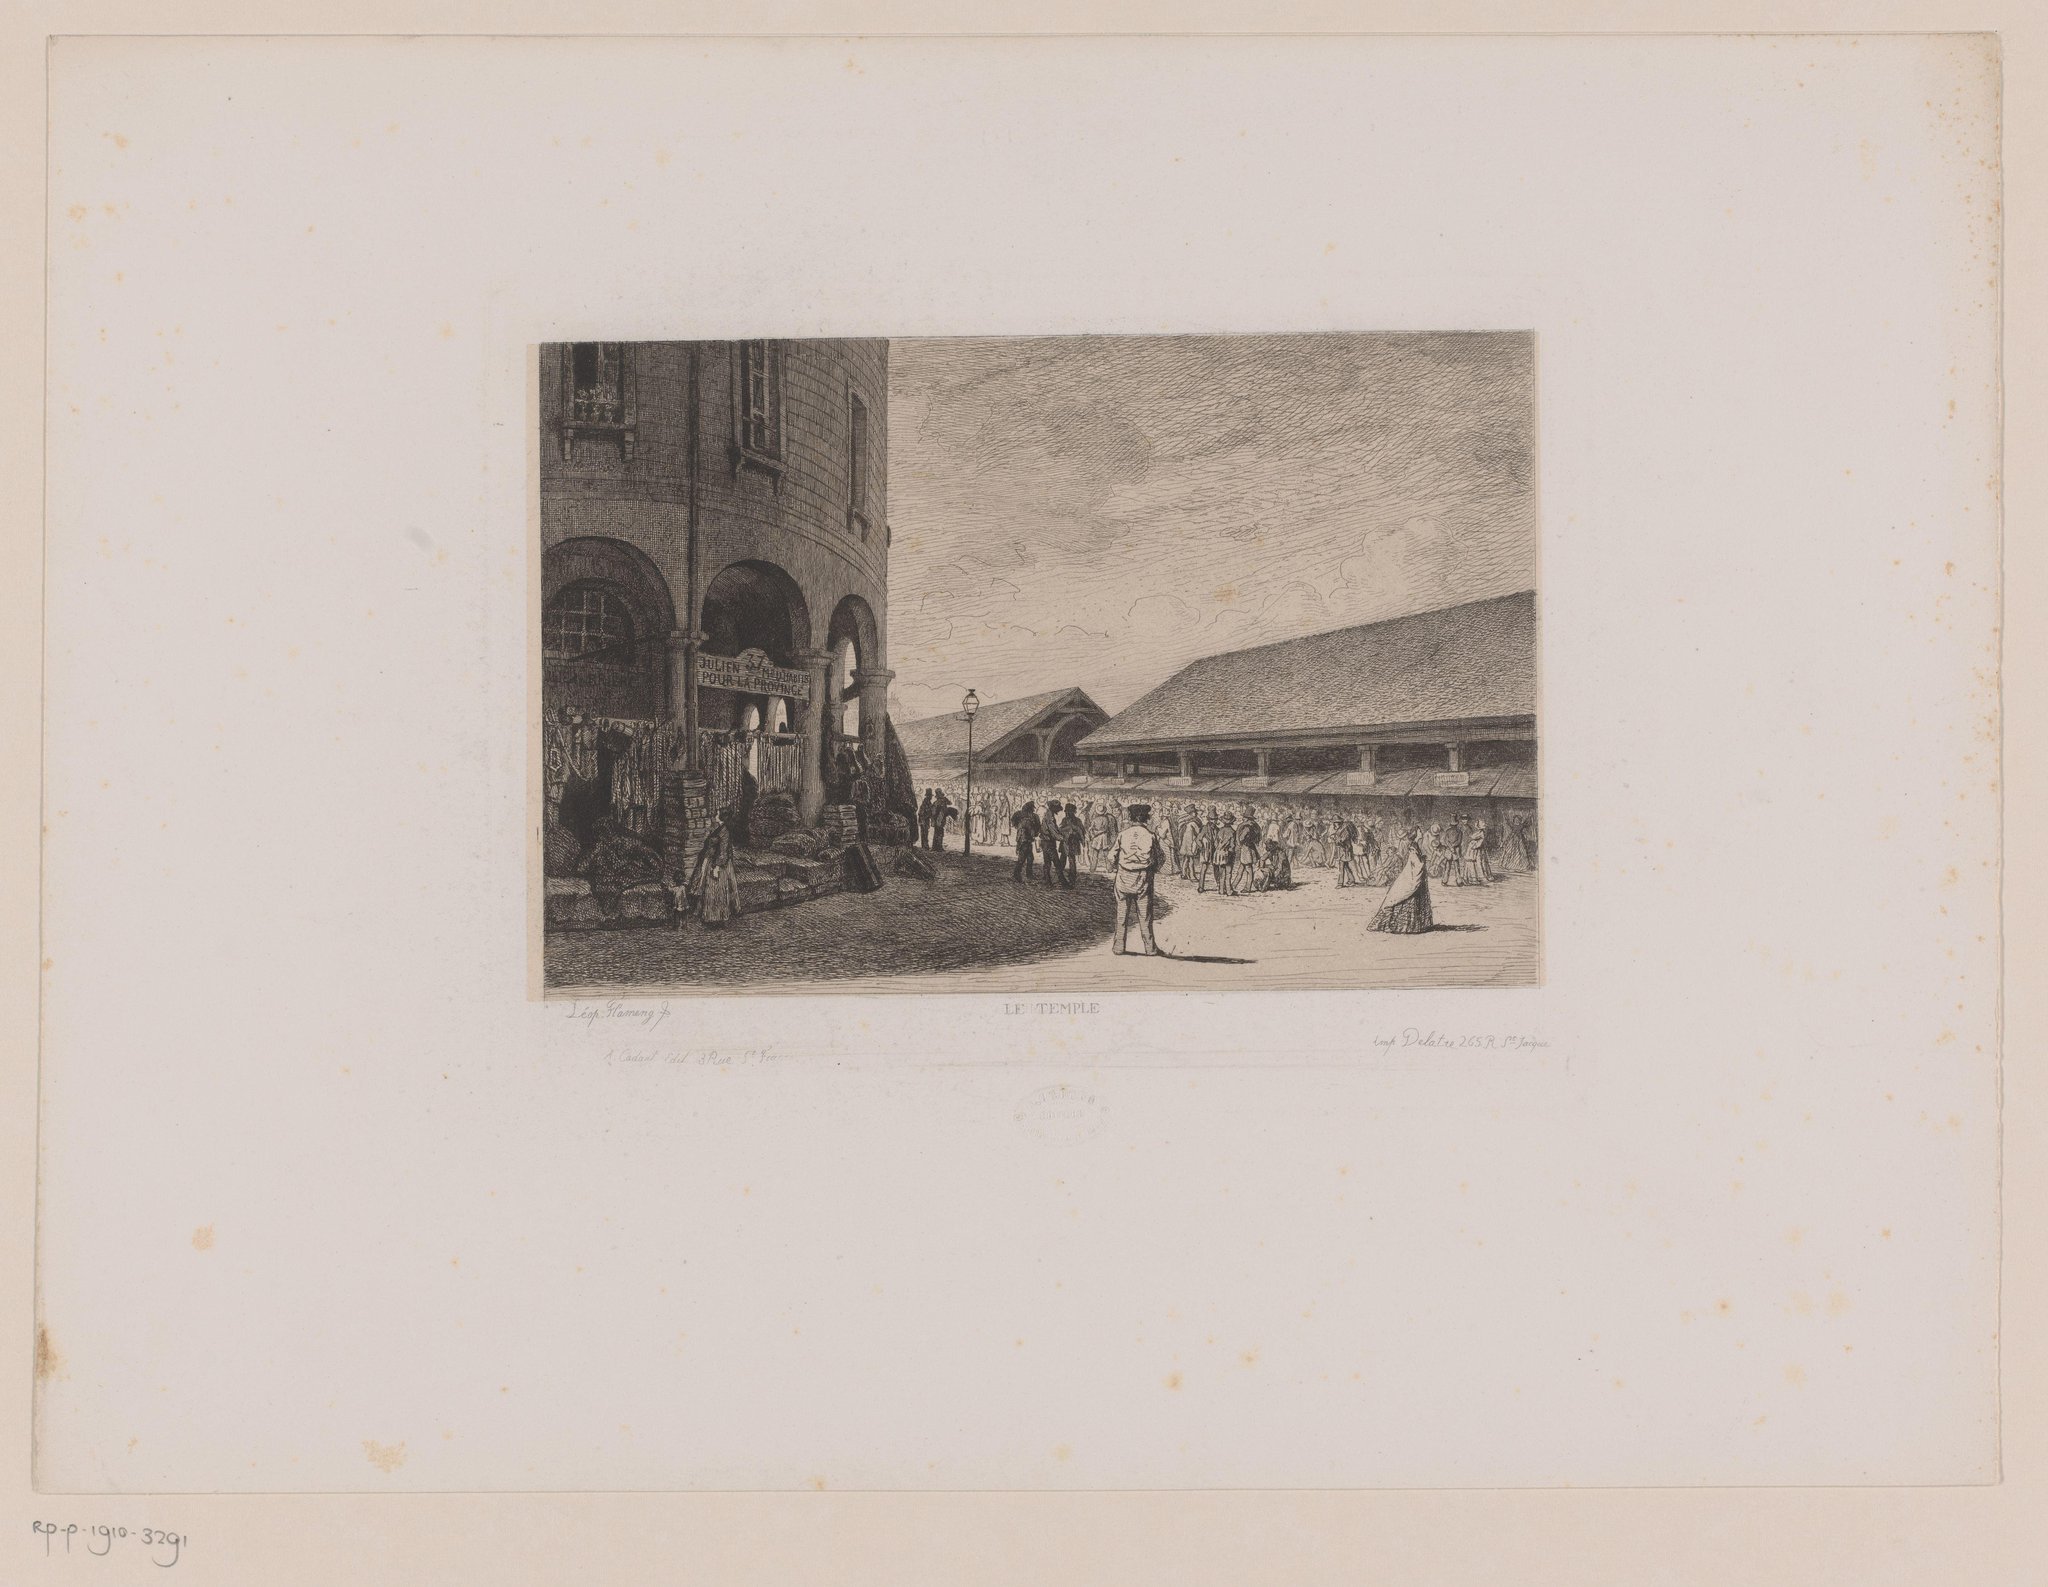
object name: print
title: Parijs komt en Parijs gaat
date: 1859-1860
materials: paper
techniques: etching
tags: market-hall, paris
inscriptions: workshop stamp: ‘A. Cadart editeur 3 rue St. Fiacre Paris’, collector's mark: Lugt 2228